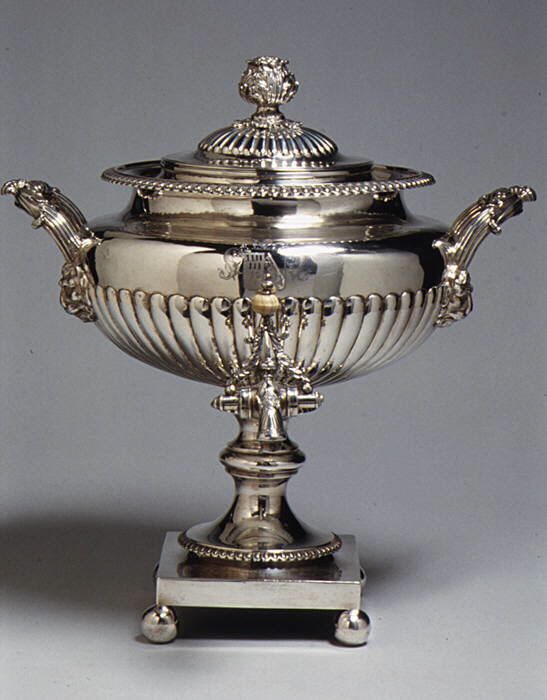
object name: hot water urn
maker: john angell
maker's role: maker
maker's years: 1815-1837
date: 1830-1831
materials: iron, silver